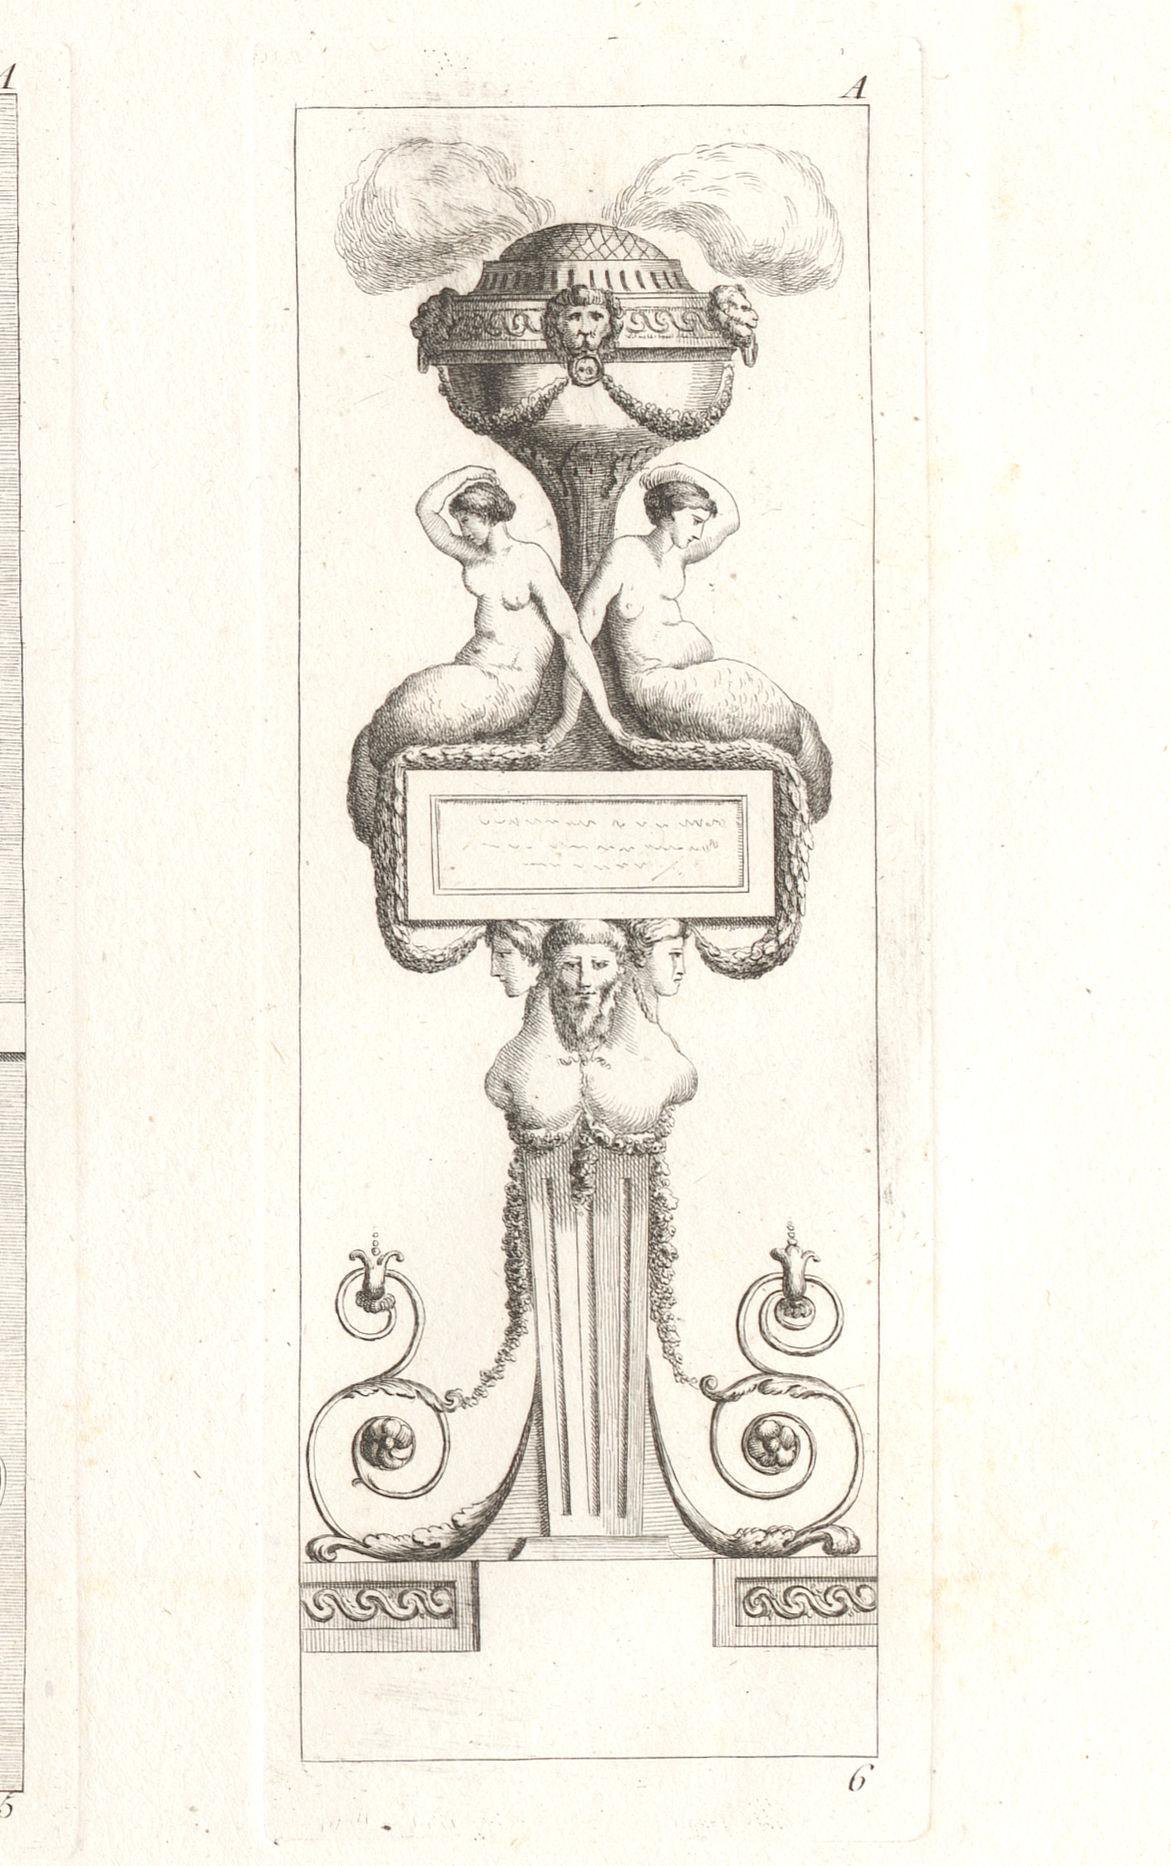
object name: album leaf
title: Premier cahier d'arabesques par F. Bo.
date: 1802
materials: paper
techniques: etching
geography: paris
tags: herms (garden ornaments), merman - aa - mermaid, siren, ornament ~ arabesque, incense-burner ~ scents, perfumes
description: Doordat dit album bestaat uit meerdere, deels eerder uitgegeven prentreeksen, is de datering niet consequent. Het geheel is op de titelpagina gedateerd op 1802. Deze reeks is niet los gedateerd. De serietitel voor het gehele werk is "Recueil d'arabesques, contenant les loges du Vatican". De andere serietitel is de titel van de specifieke reeks binnen het geheel.